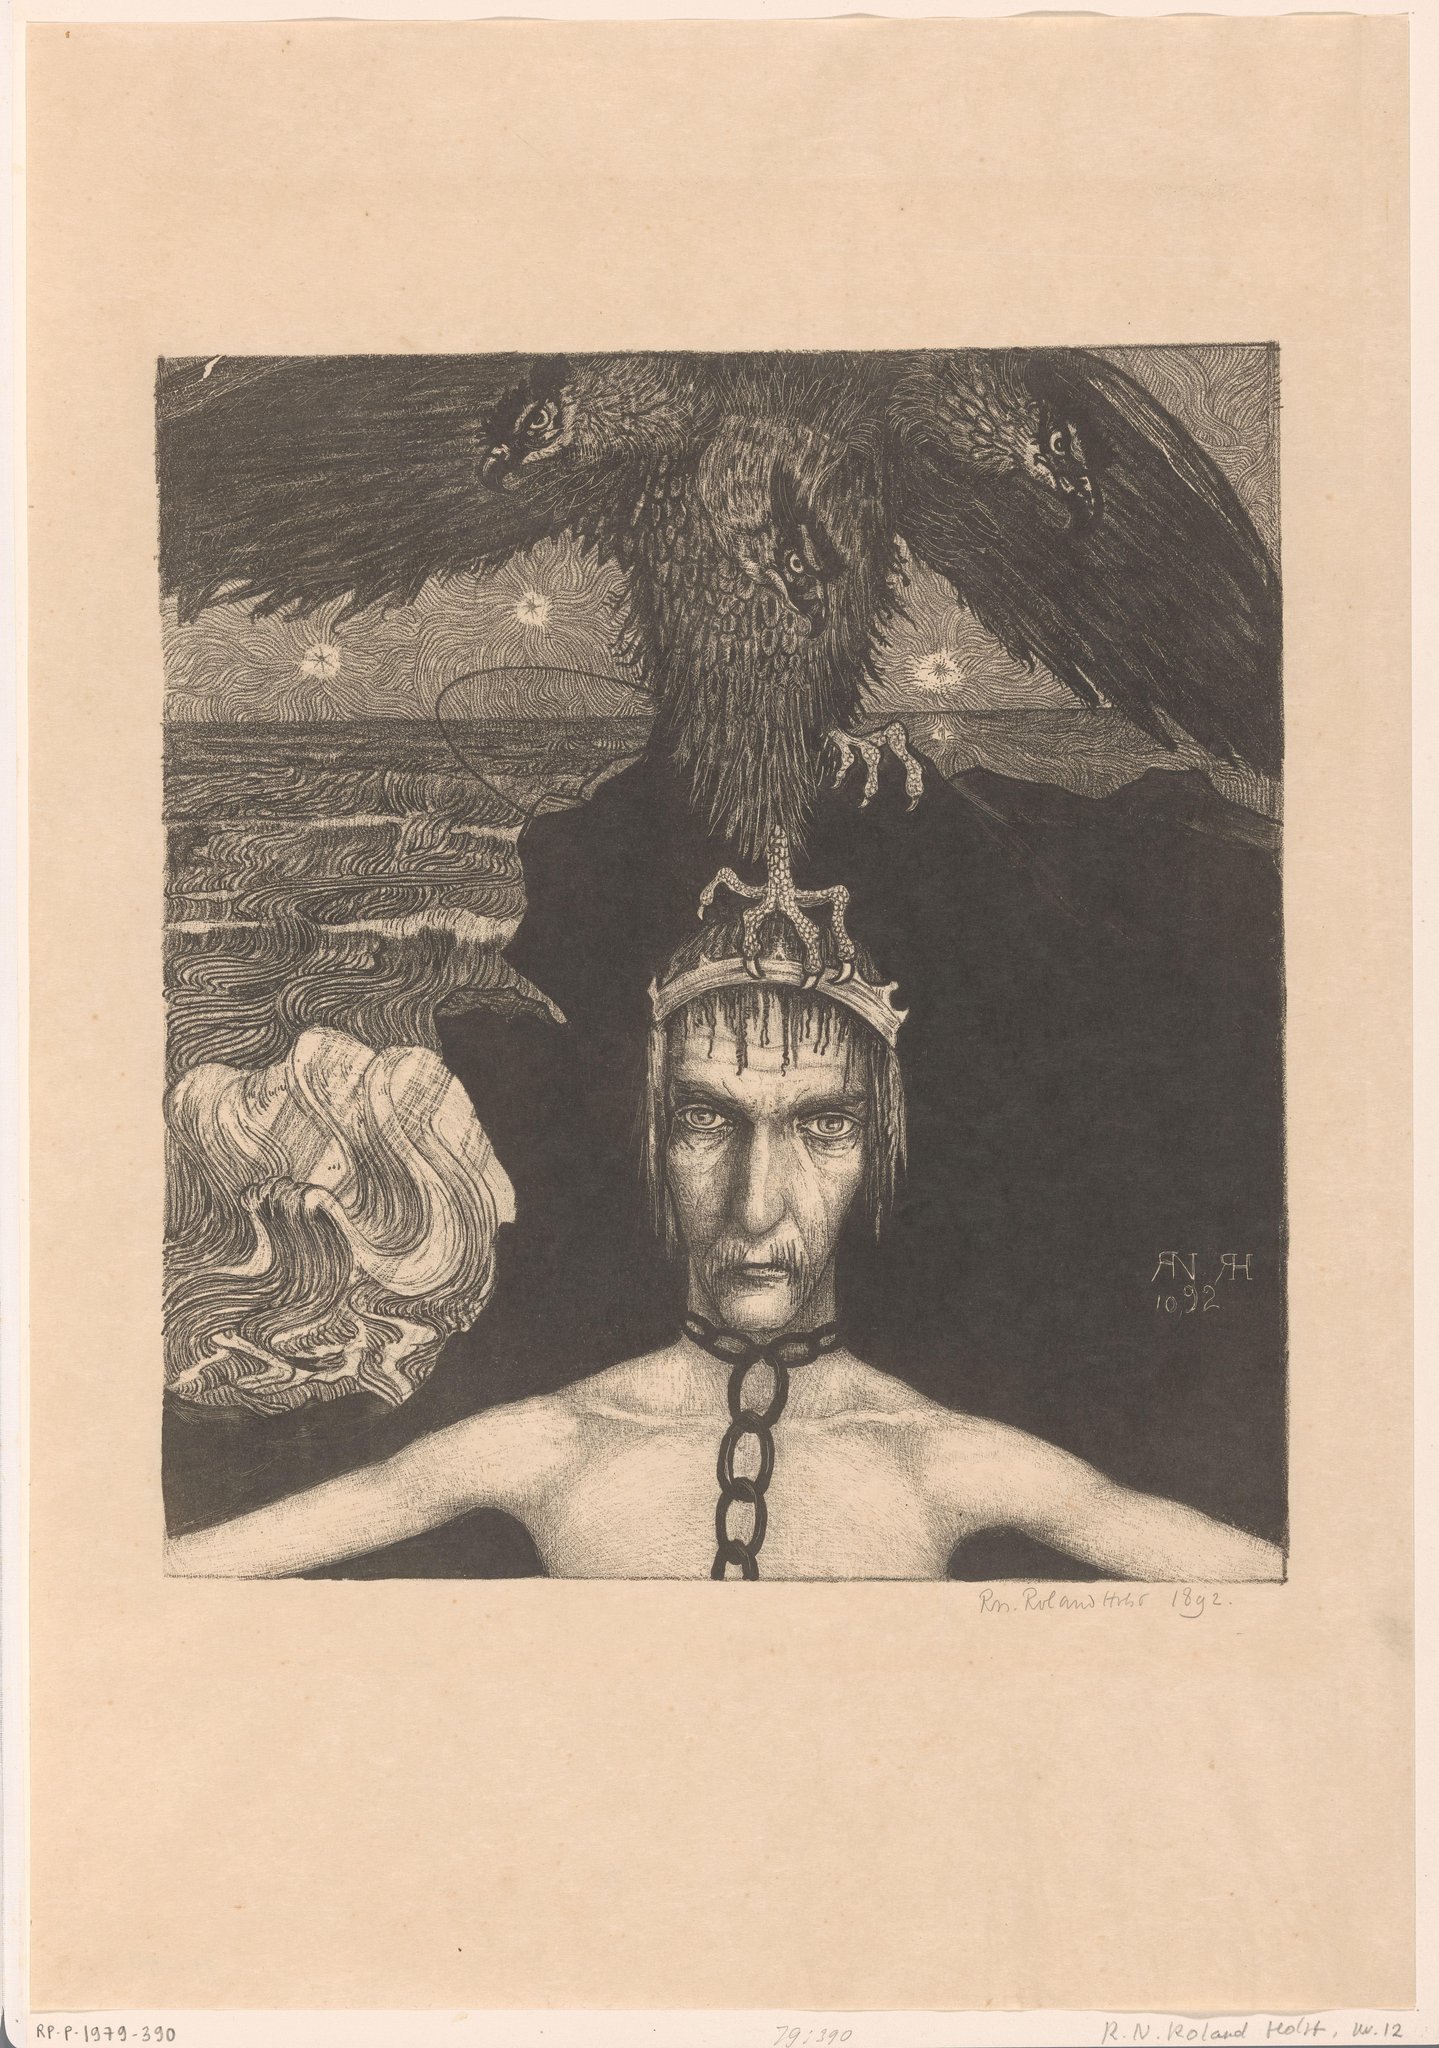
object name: print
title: Geketende man met driekoppige roofvogel op het hoofd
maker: richard nicolaüs roland holst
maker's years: 1868-1938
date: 1810-1892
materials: paper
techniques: lithograph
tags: wave, crown (symbol of sovereignty), three-headed beast, rocky coast, predatory birds, stars, tools, aids, implements ~ crafts and industries: chain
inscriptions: collector's mark: Lugt 2228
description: Op de voorgrond een man met ontbloot bovenlijf die ketenen draagt om zijn nek. Op zijn hoofd een kroon en een roofvogel met drie koppen. Op de achtergrond een rotsachtige kust en een golvende zee. Aan de nachtelijke hemel drie steren.